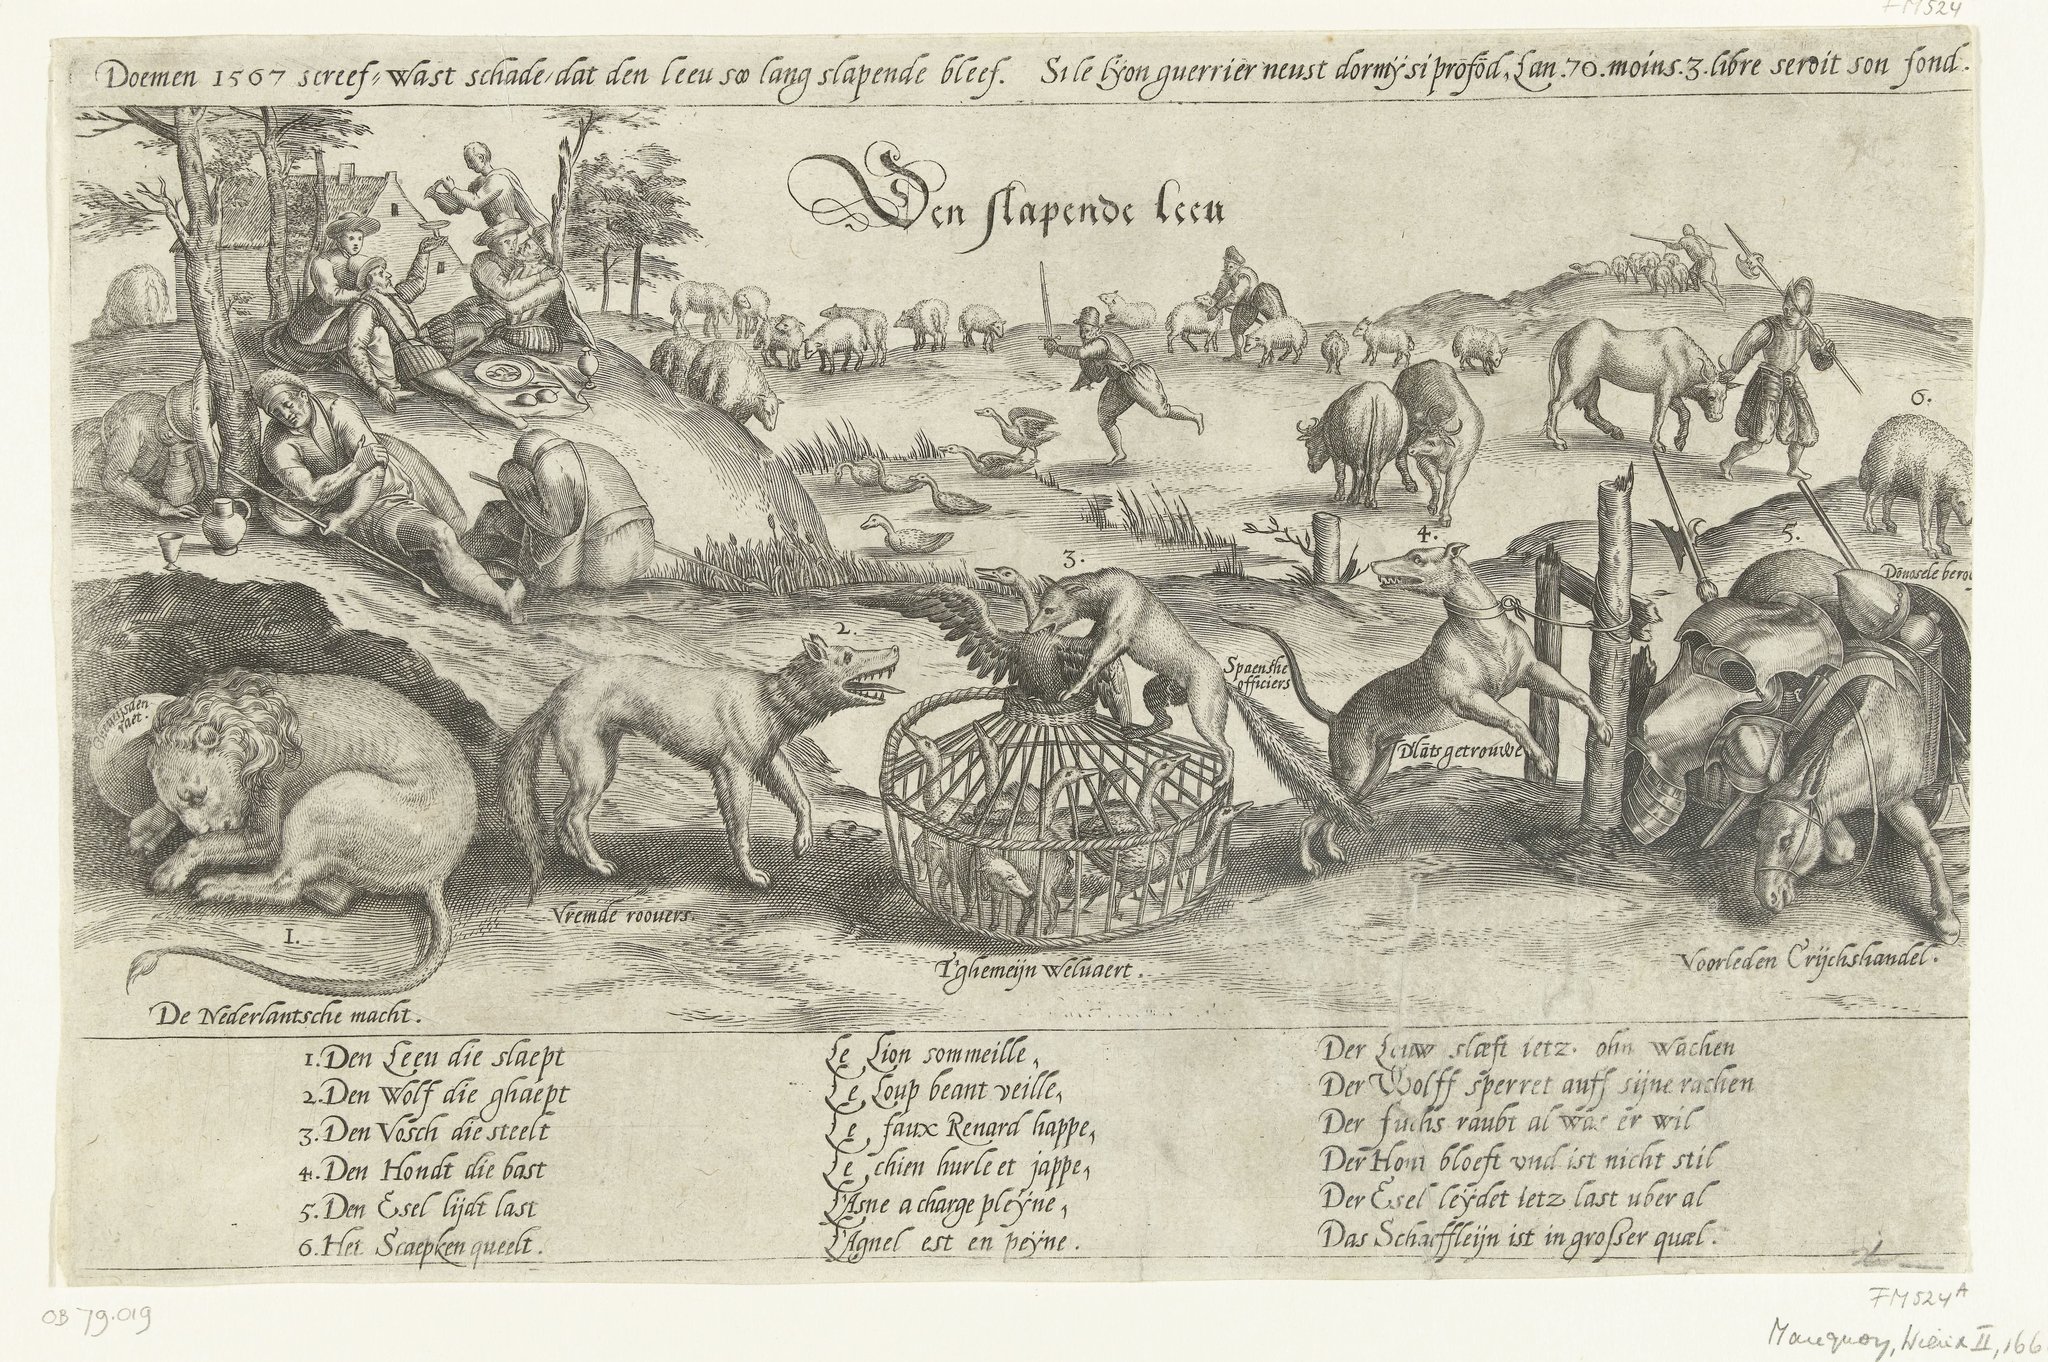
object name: propagandaprent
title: De slapende leeuw, 1567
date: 1578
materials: paper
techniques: engraving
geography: southern netherlands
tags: sleeping; unconsciousness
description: Allegorie op politieke situatie in de Nederlanden in het jaar 1567. Alle partijen verbeeld door dieren. Terwijl de Nederlandse Leeuw slaapt roven de vos en de wolf ganzen uit een kooi. Op de achtergrond slapende herders en plezier makende heren terwijl het vee gestolen wordt. Met opschrift van 1 regel boven de voorstelling en in het onderschrift de legenda 1-6 in 3 verzen van 6 regels in het Nederlands, Frans en Duits.